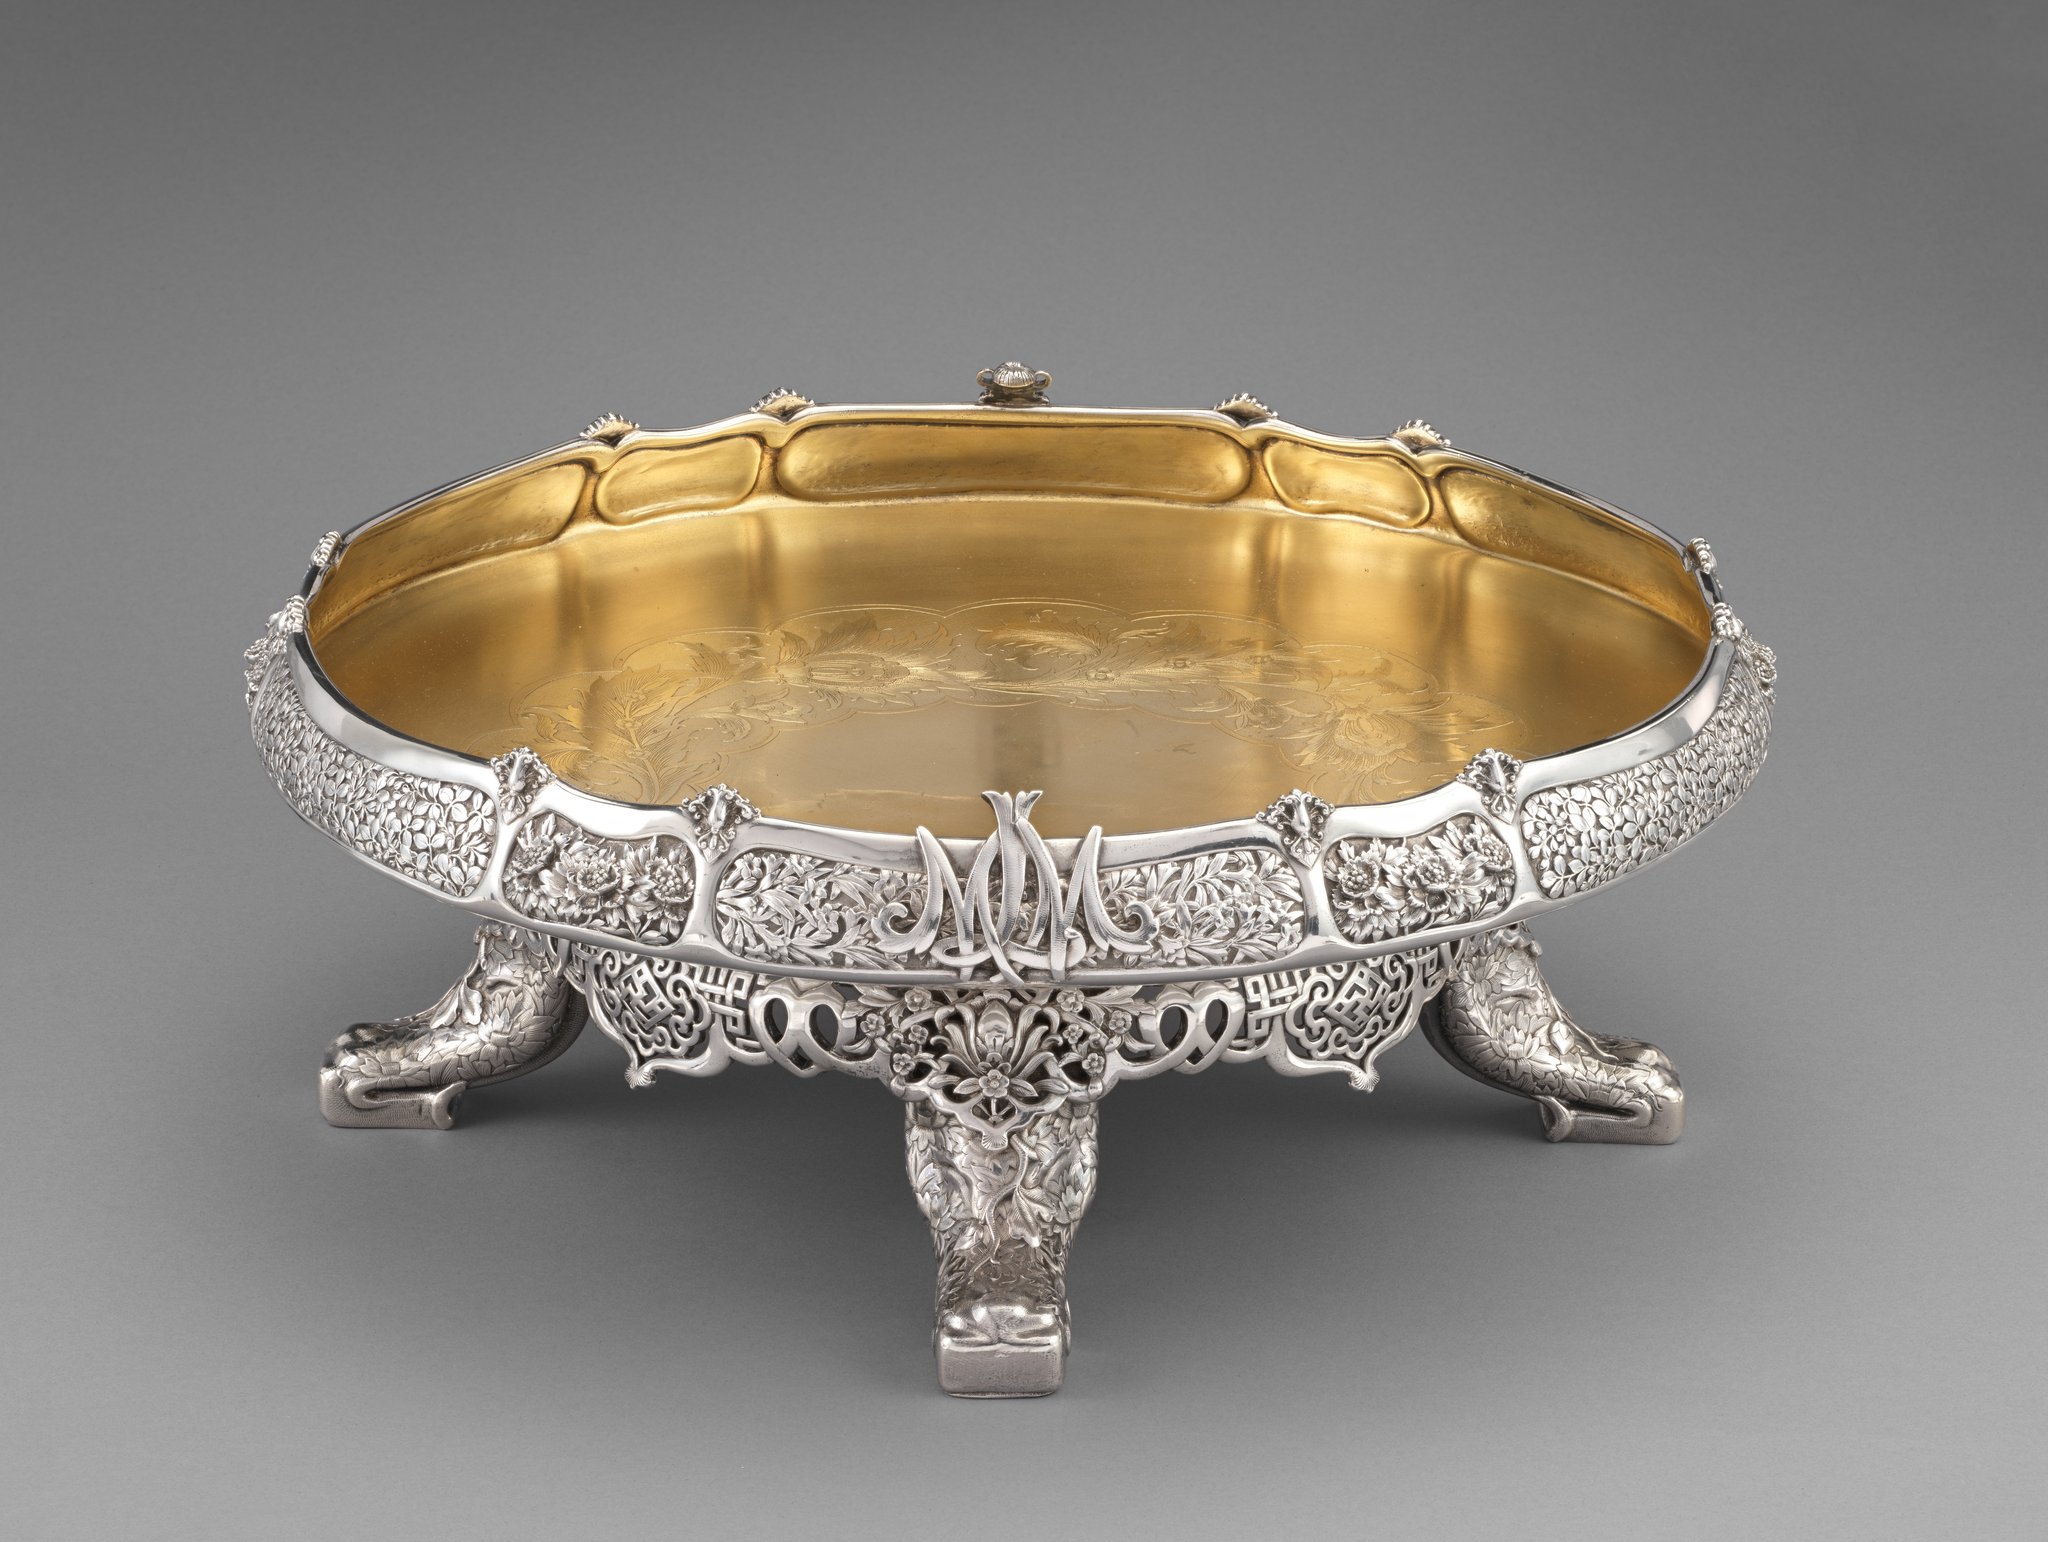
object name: ice cream dish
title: Ice Cream Dish from Mackay Service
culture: american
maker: tiffany & co.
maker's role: manufactory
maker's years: 1837-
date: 1878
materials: silver, silver gilt